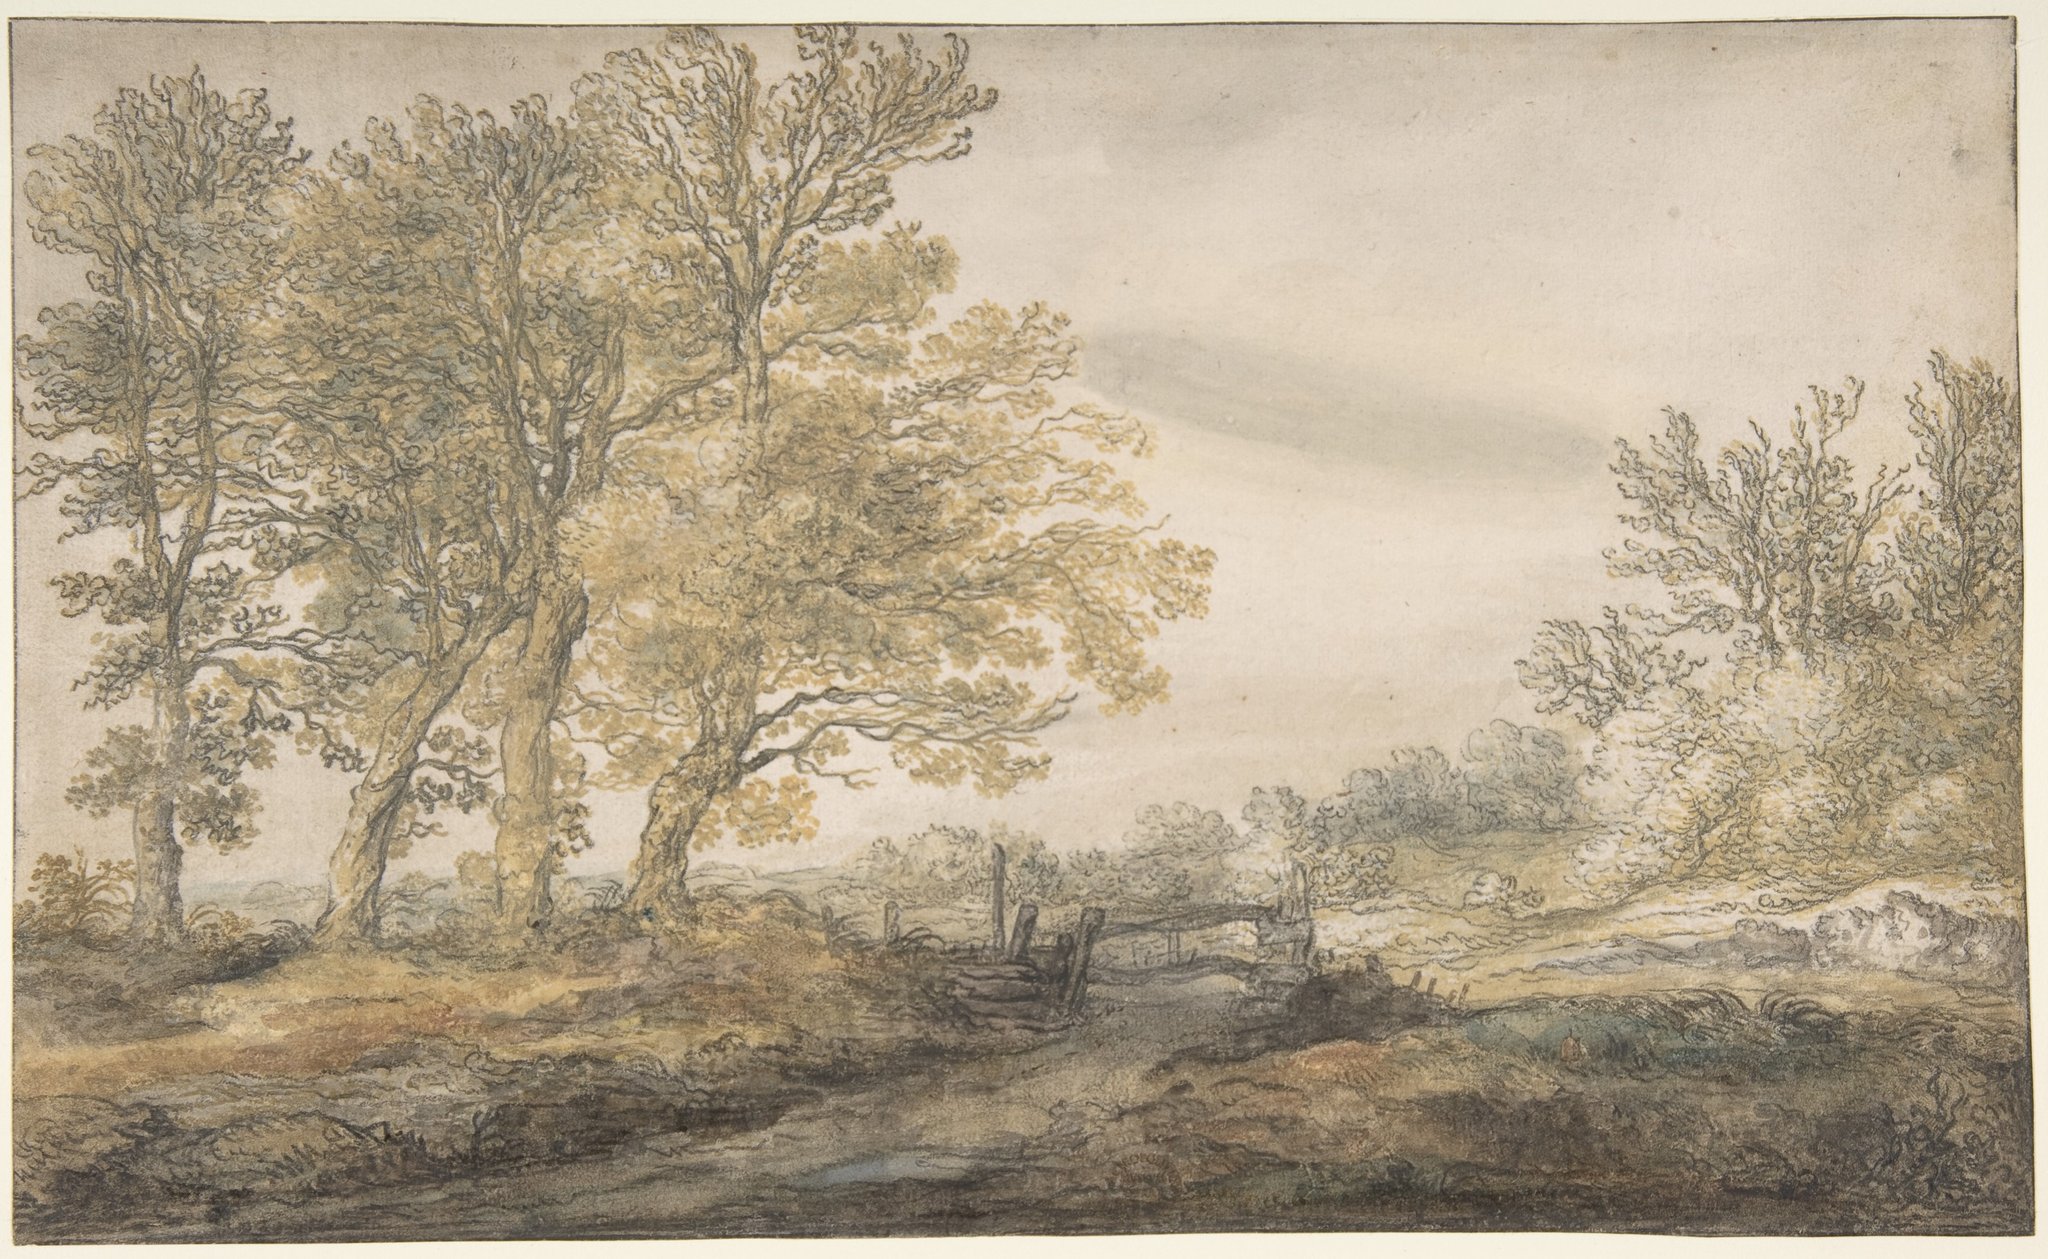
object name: drawing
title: Landscape with Trees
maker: aelbert cuyp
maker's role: artist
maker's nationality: dutch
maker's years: 1620-1691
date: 1635-1691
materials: chalk, watercolor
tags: landscapes